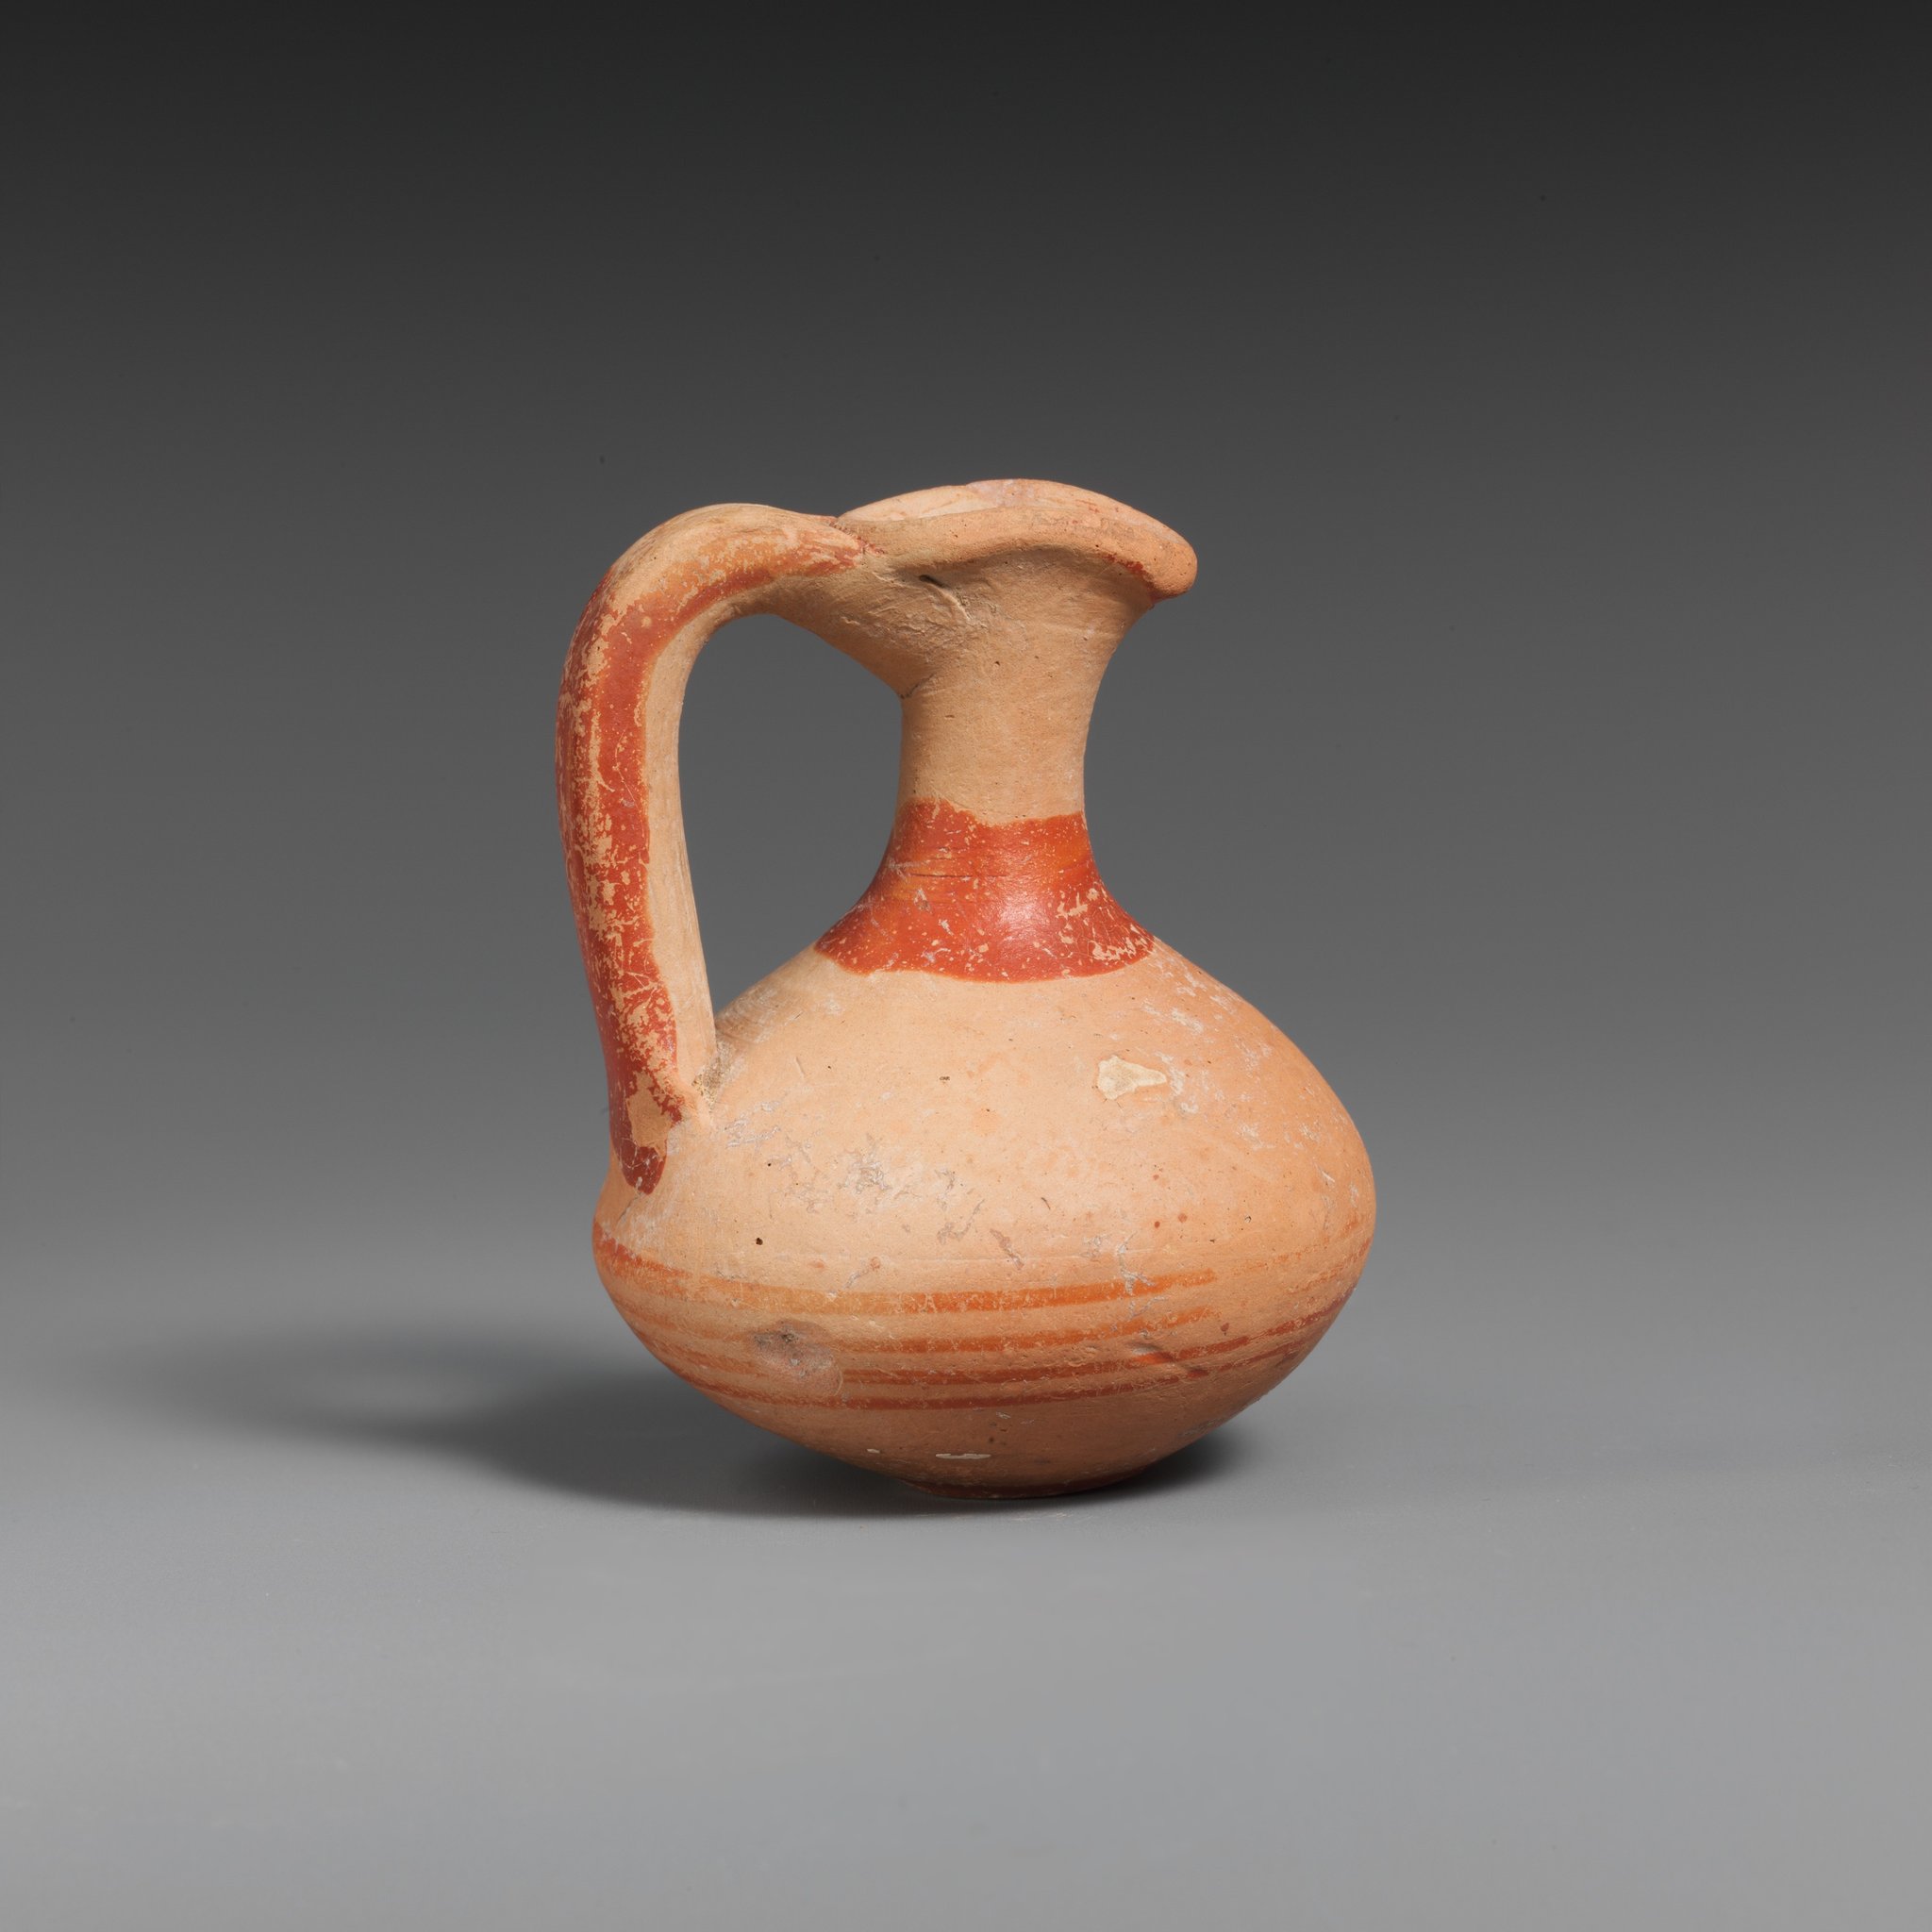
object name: oinochoe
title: Terracotta oinochoe (jug)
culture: greek, attic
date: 700-668 BCE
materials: terracotta